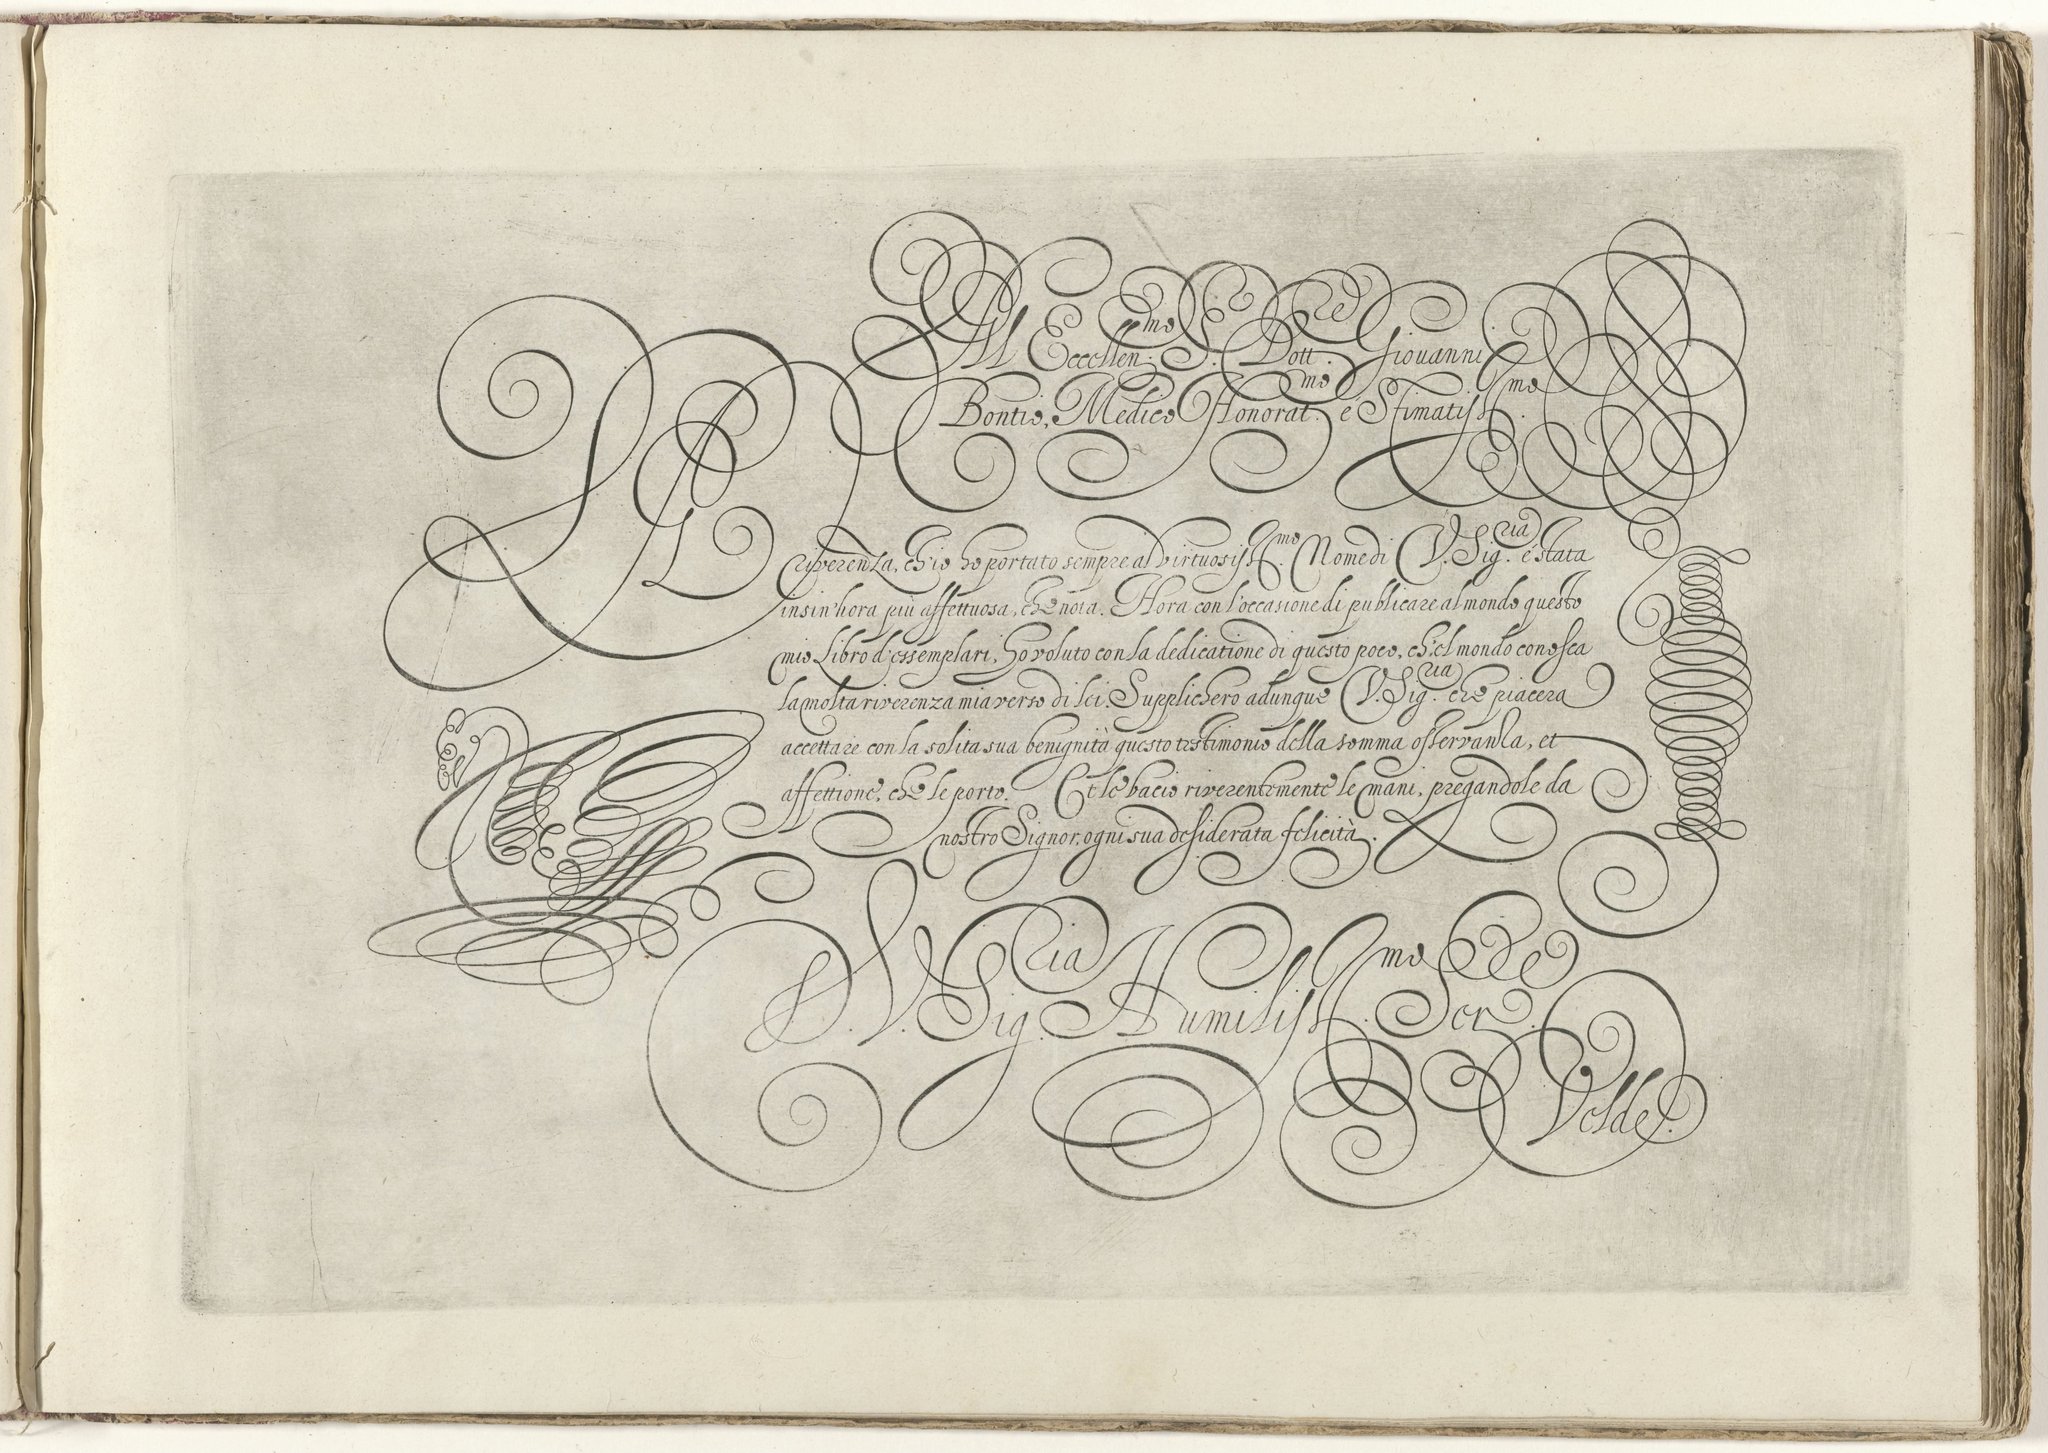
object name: ornament print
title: Spieghel der schrijfkonste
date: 1605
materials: paper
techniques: engraving, intaglio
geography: amsterdam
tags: water-birds: swan, calligraphy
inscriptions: collector's mark: Lugt 2760, collector's mark: Lugt 2228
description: Schrijfvoorbeeld met de aanhef: Al eccellen. S. dott. Giovanni Bontio ... Daaronder zeven regels in het Italiaans: De riverenza ch'io ho portato ... Ondertekend: D.V. Sig. Humiliss Ser. Velde. Links een zwaan in krulwerk. De prent maakt deel uit van een album.